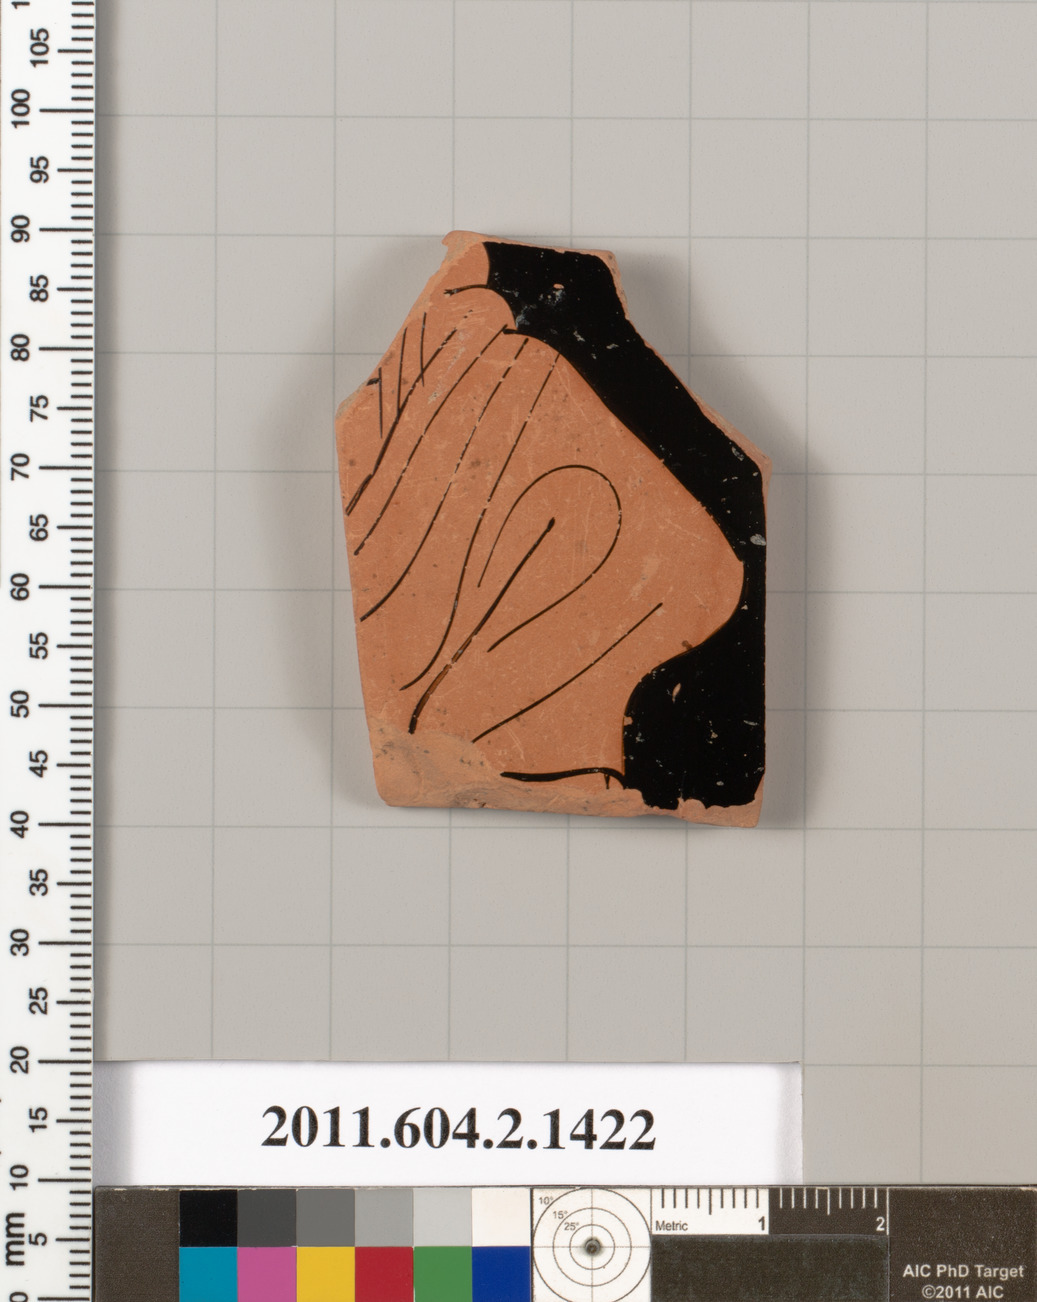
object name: skyphos fragment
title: Terracotta fragment of a skyphos (deep drinking cup)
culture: greek, attic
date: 450-430 BCE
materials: terracotta